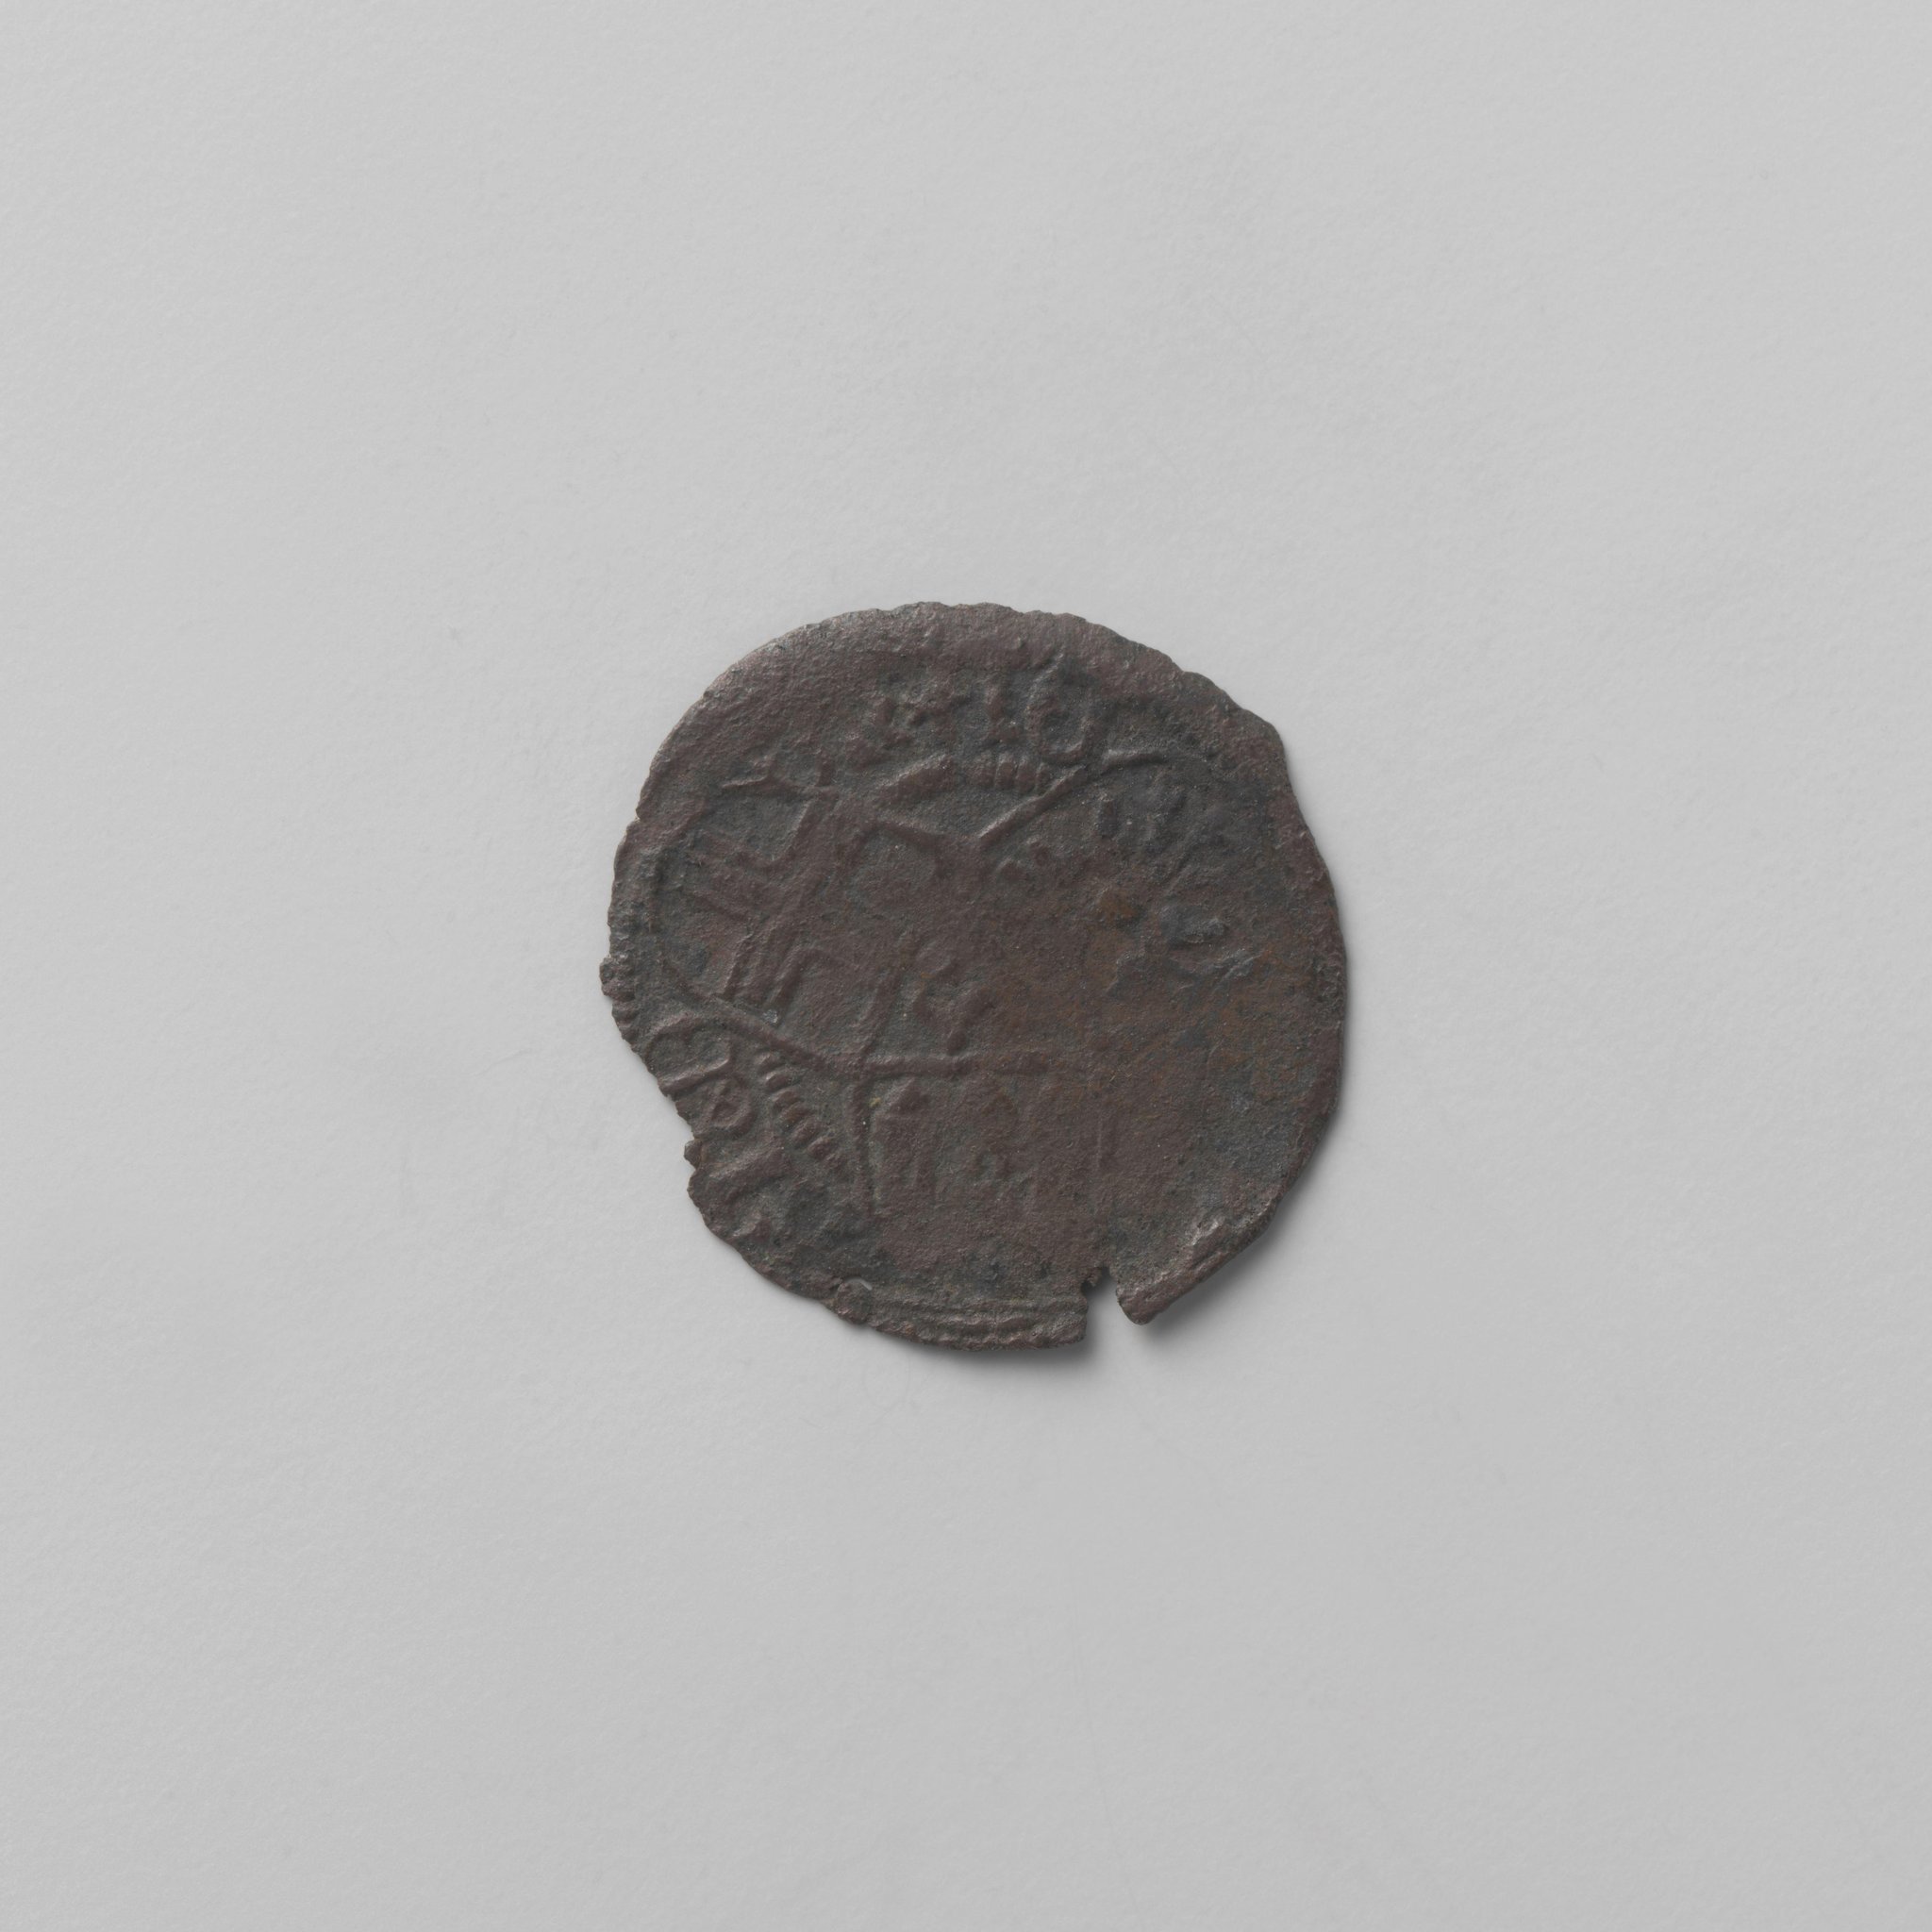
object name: coin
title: Drie Steden, halve plak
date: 1534-1579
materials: silver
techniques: striking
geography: deventer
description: Koper-zilveren munt. Voorzijde: versierd lang kruis. In het centrum een ster. Keerzijde: wapenschilden van de Drie Steden, in het centrum letter D.